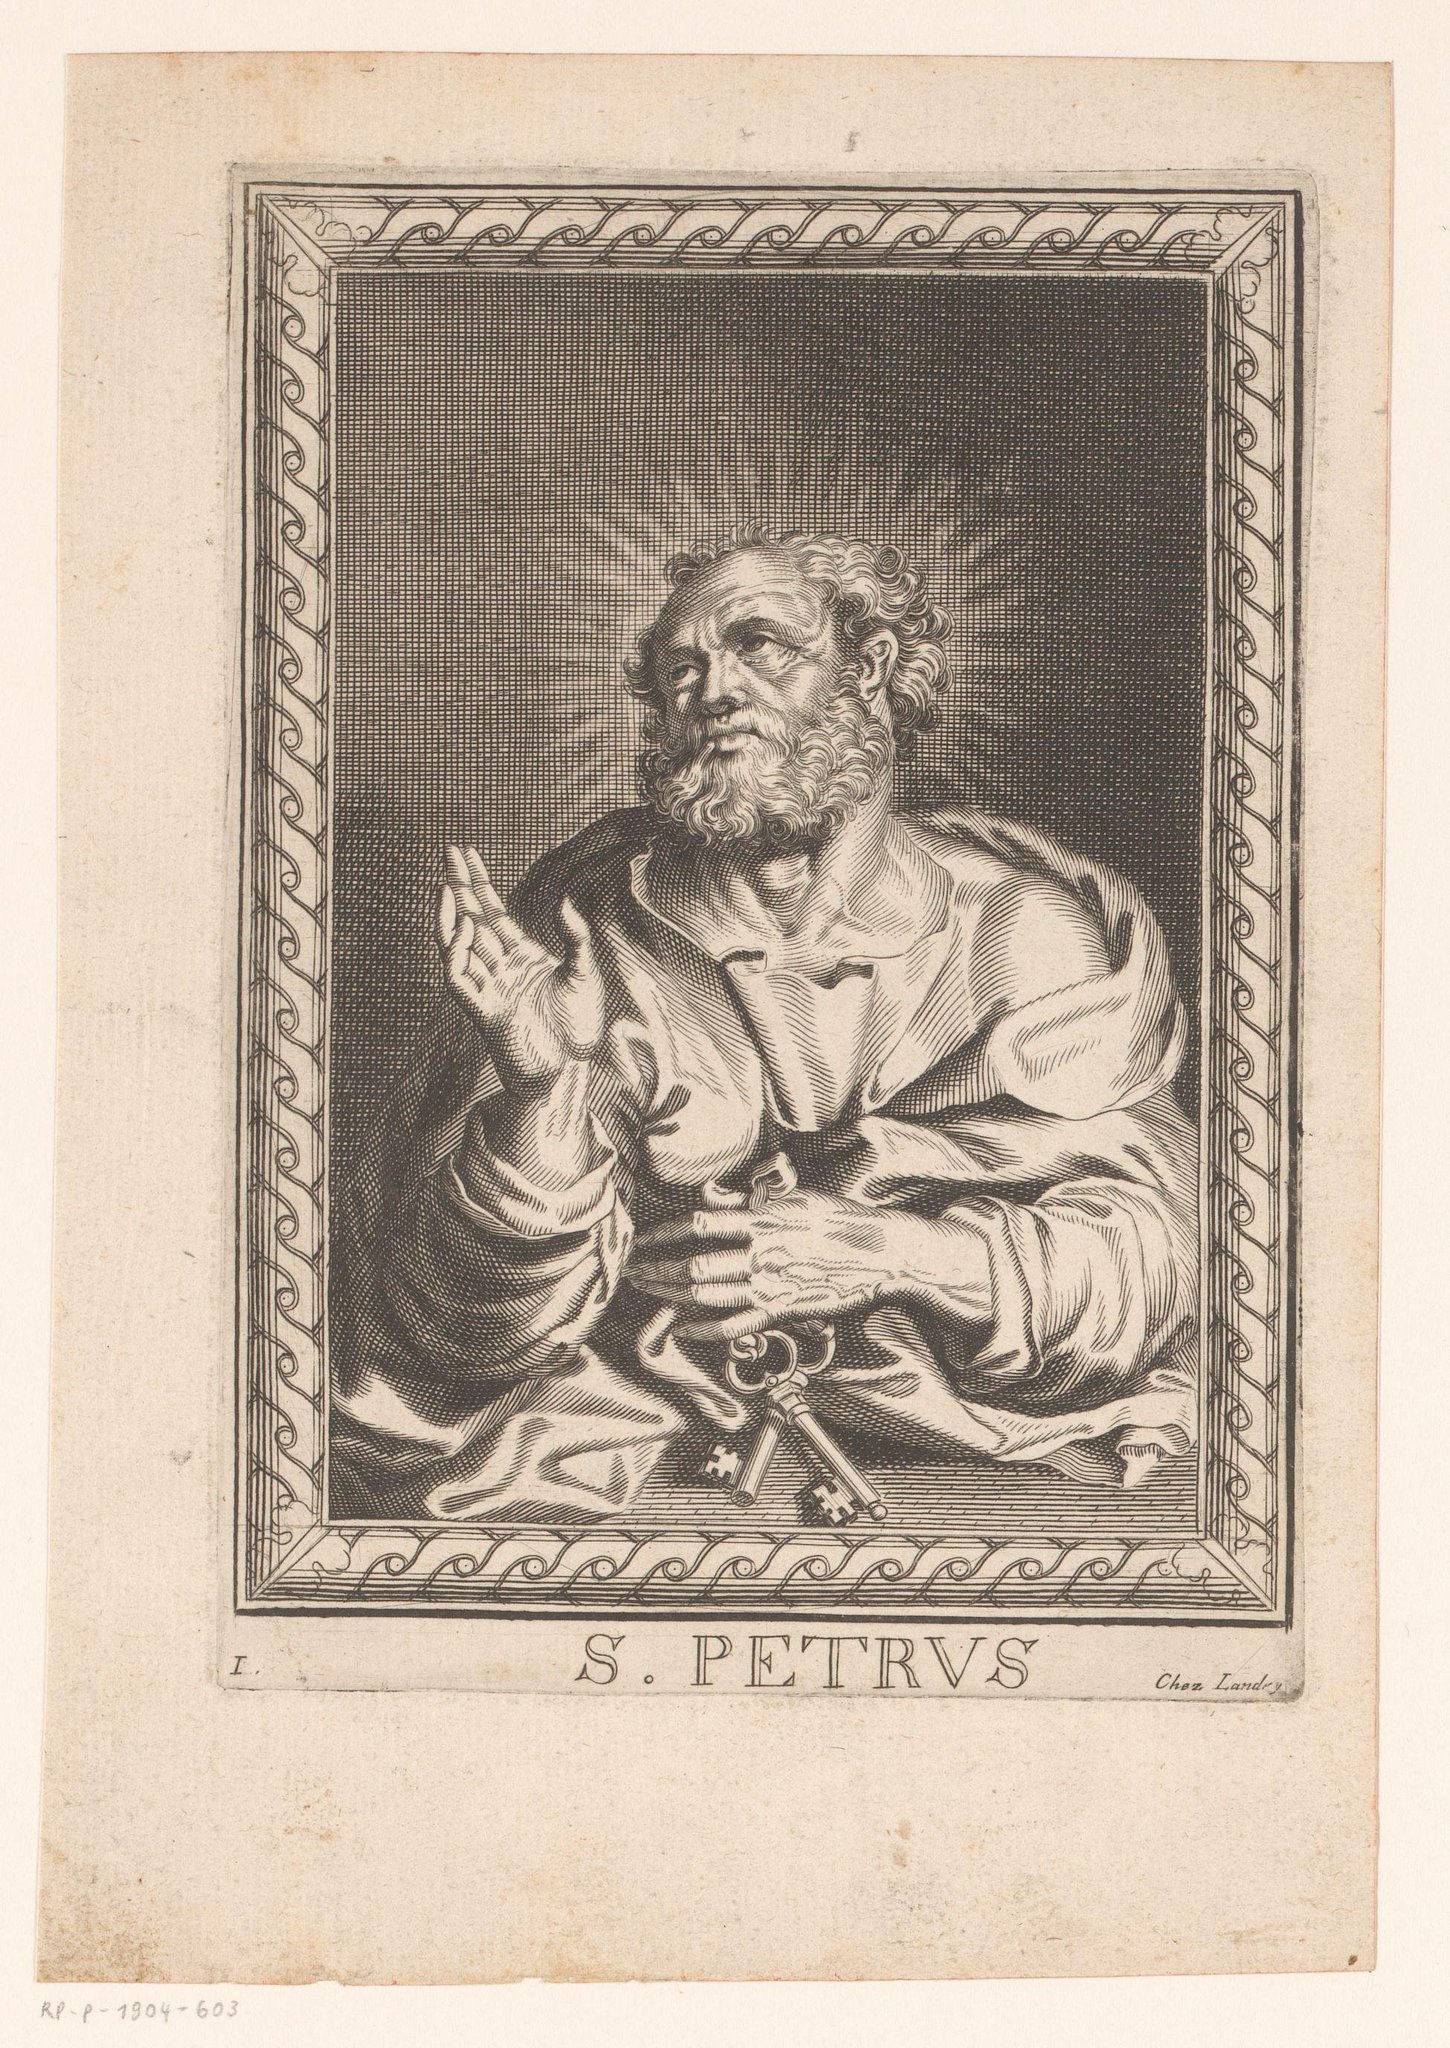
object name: print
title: H. Petrus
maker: pierre landry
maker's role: print maker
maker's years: 1630-1701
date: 1640-1701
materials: paper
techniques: engraving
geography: france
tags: the apostle peter, first bishop of rome; possible attributes: book, cock, (upturned) cross, (triple) crozier, fish, key, scroll, ship, tiara - portrait of male saint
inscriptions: collector's mark: Lugt 2228